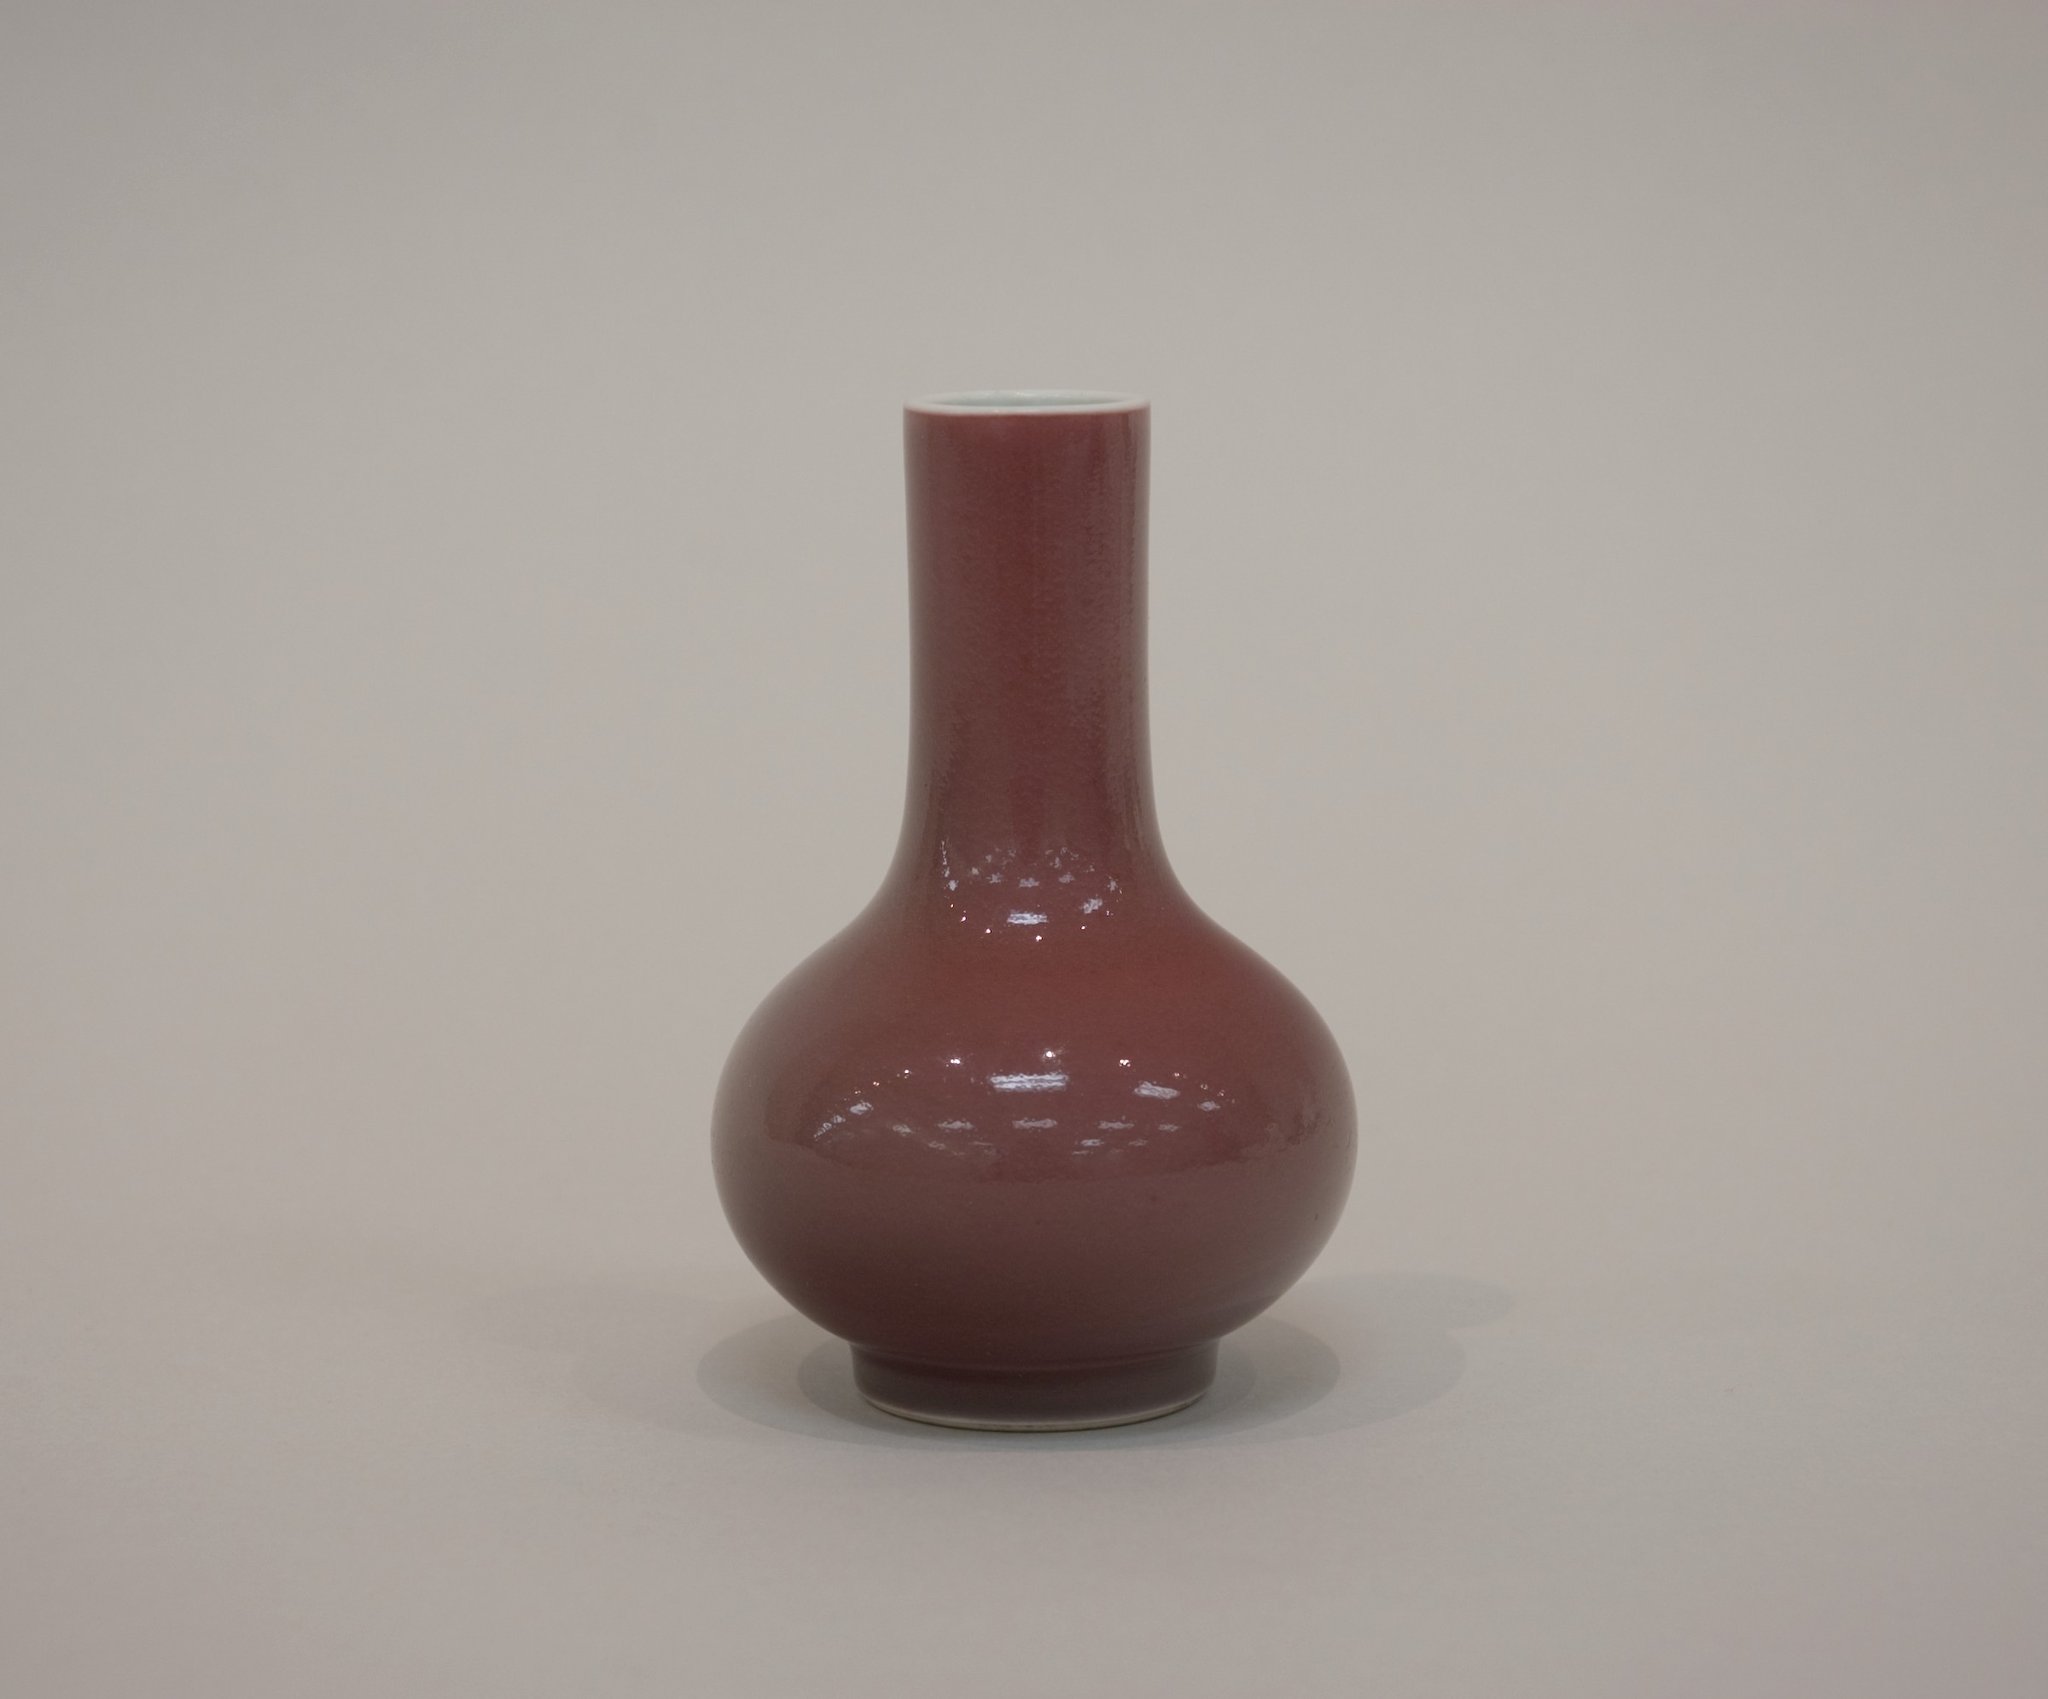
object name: bottle vase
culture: chinese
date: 1701-1733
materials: copper, glaze, porcelain